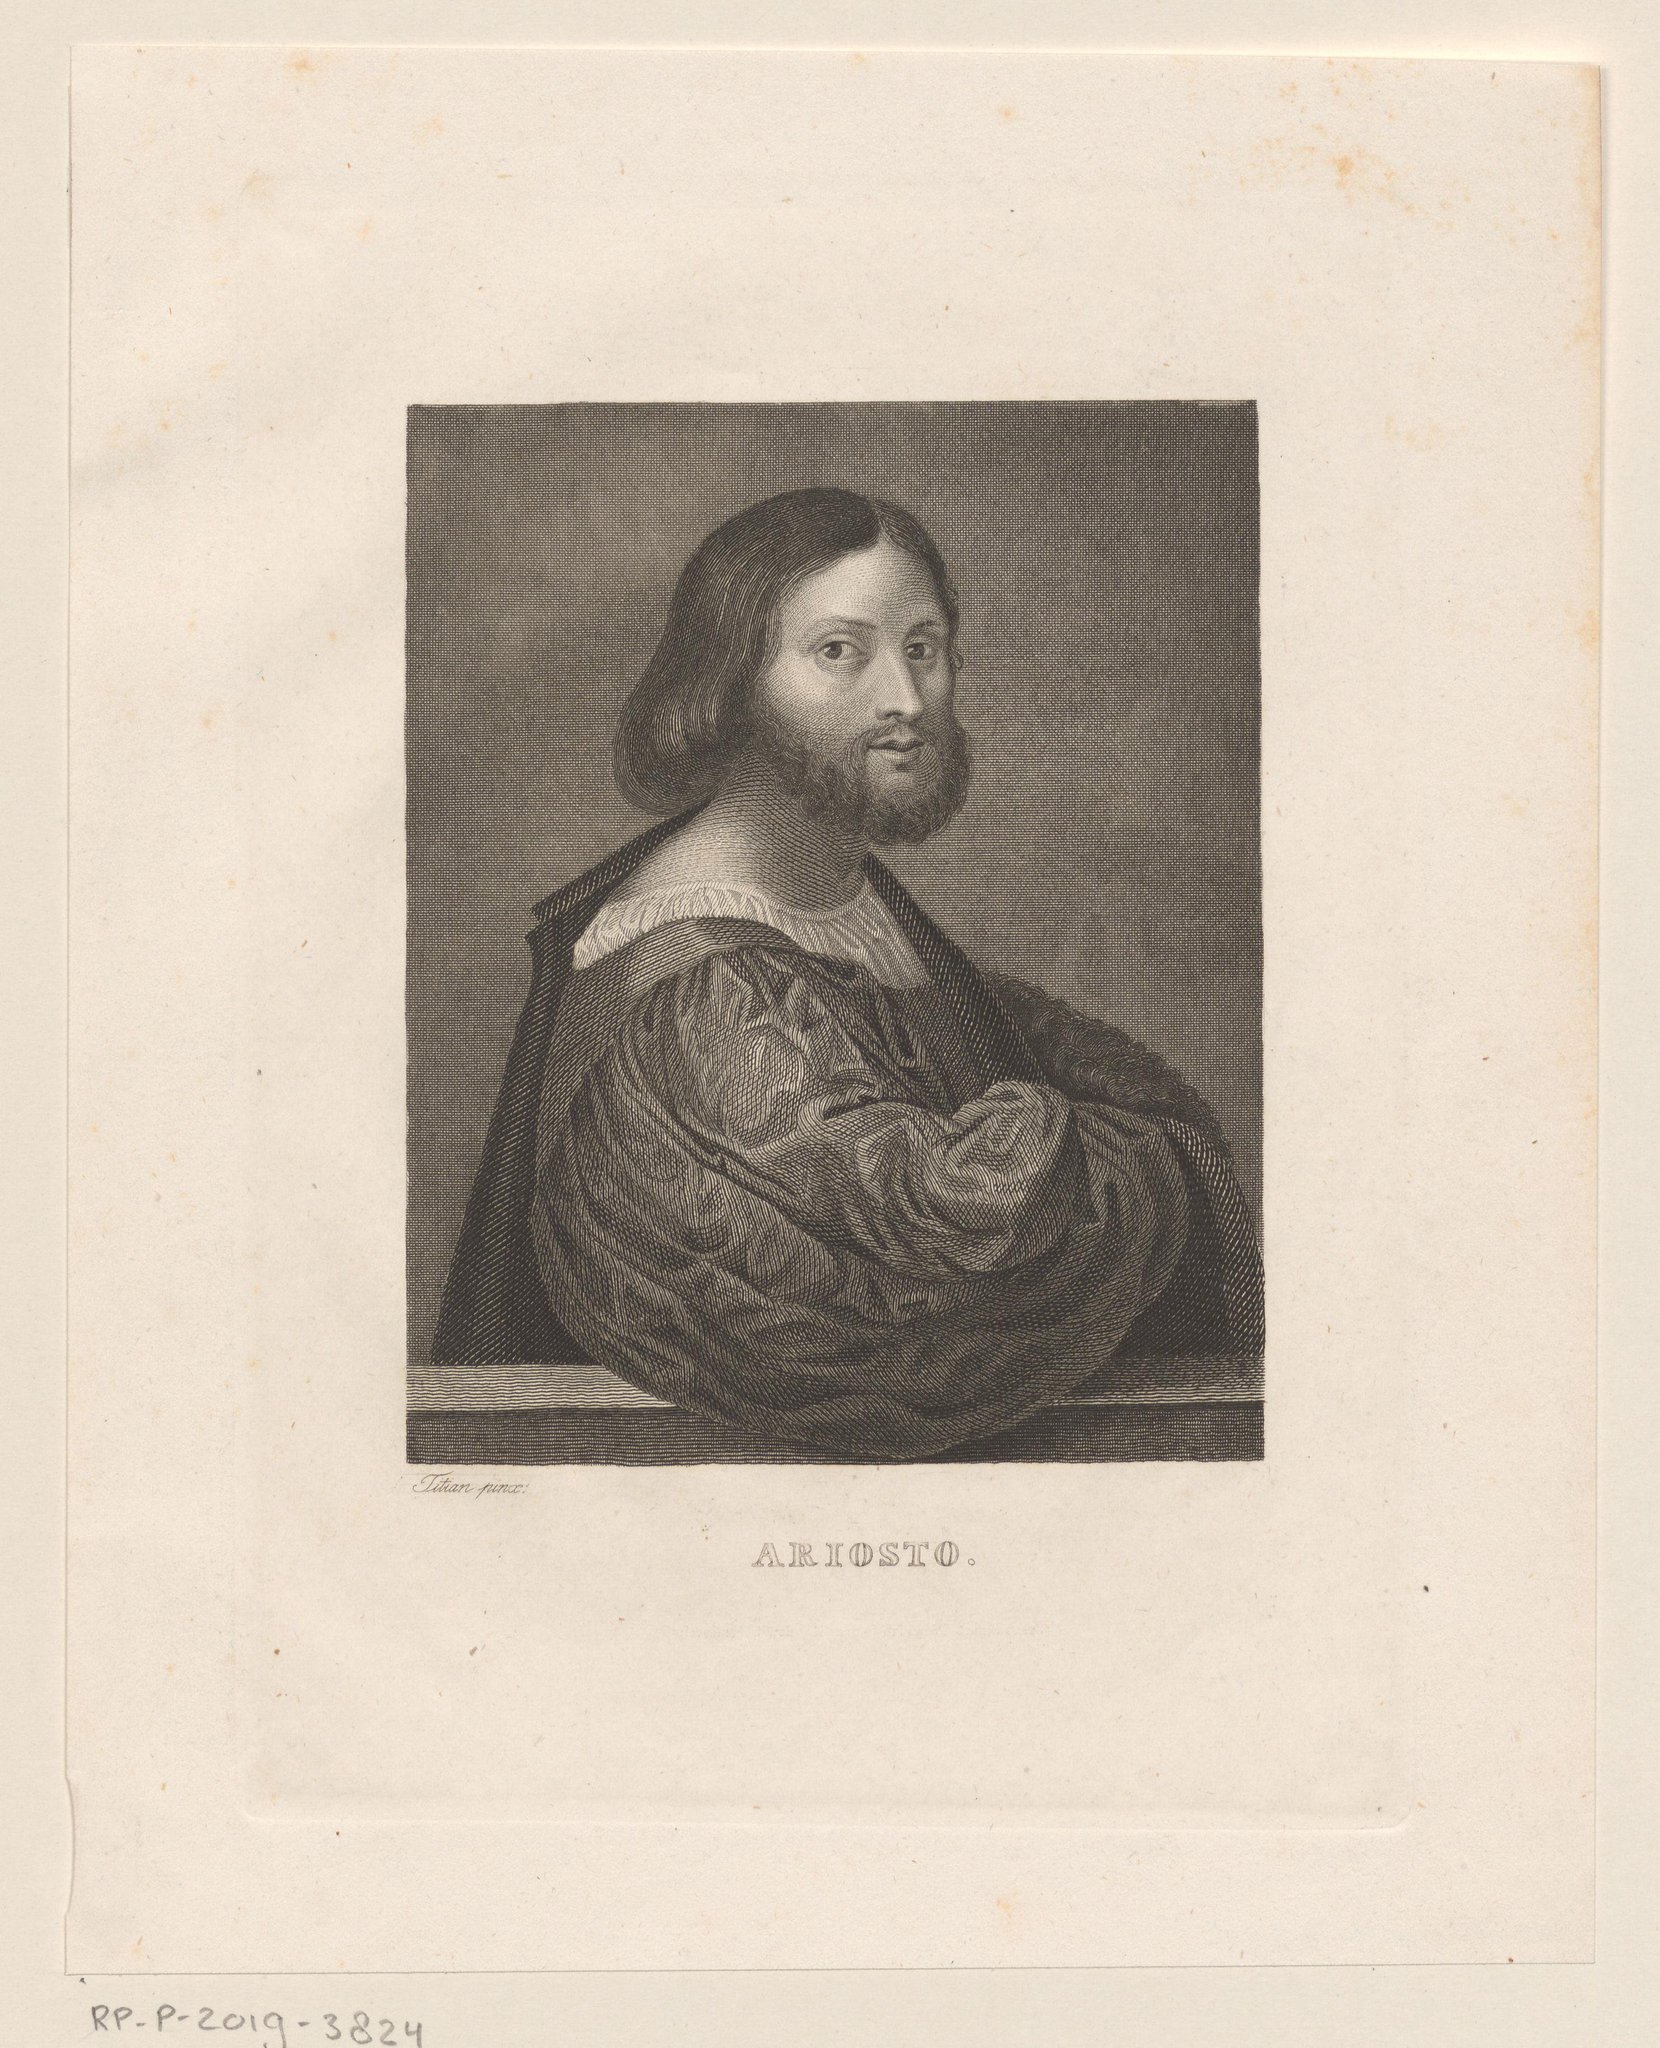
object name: print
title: Portret van Ludovico Ariosto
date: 1800-1849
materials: paper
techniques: engraving, etching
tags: ludovico ariosto, historical persons